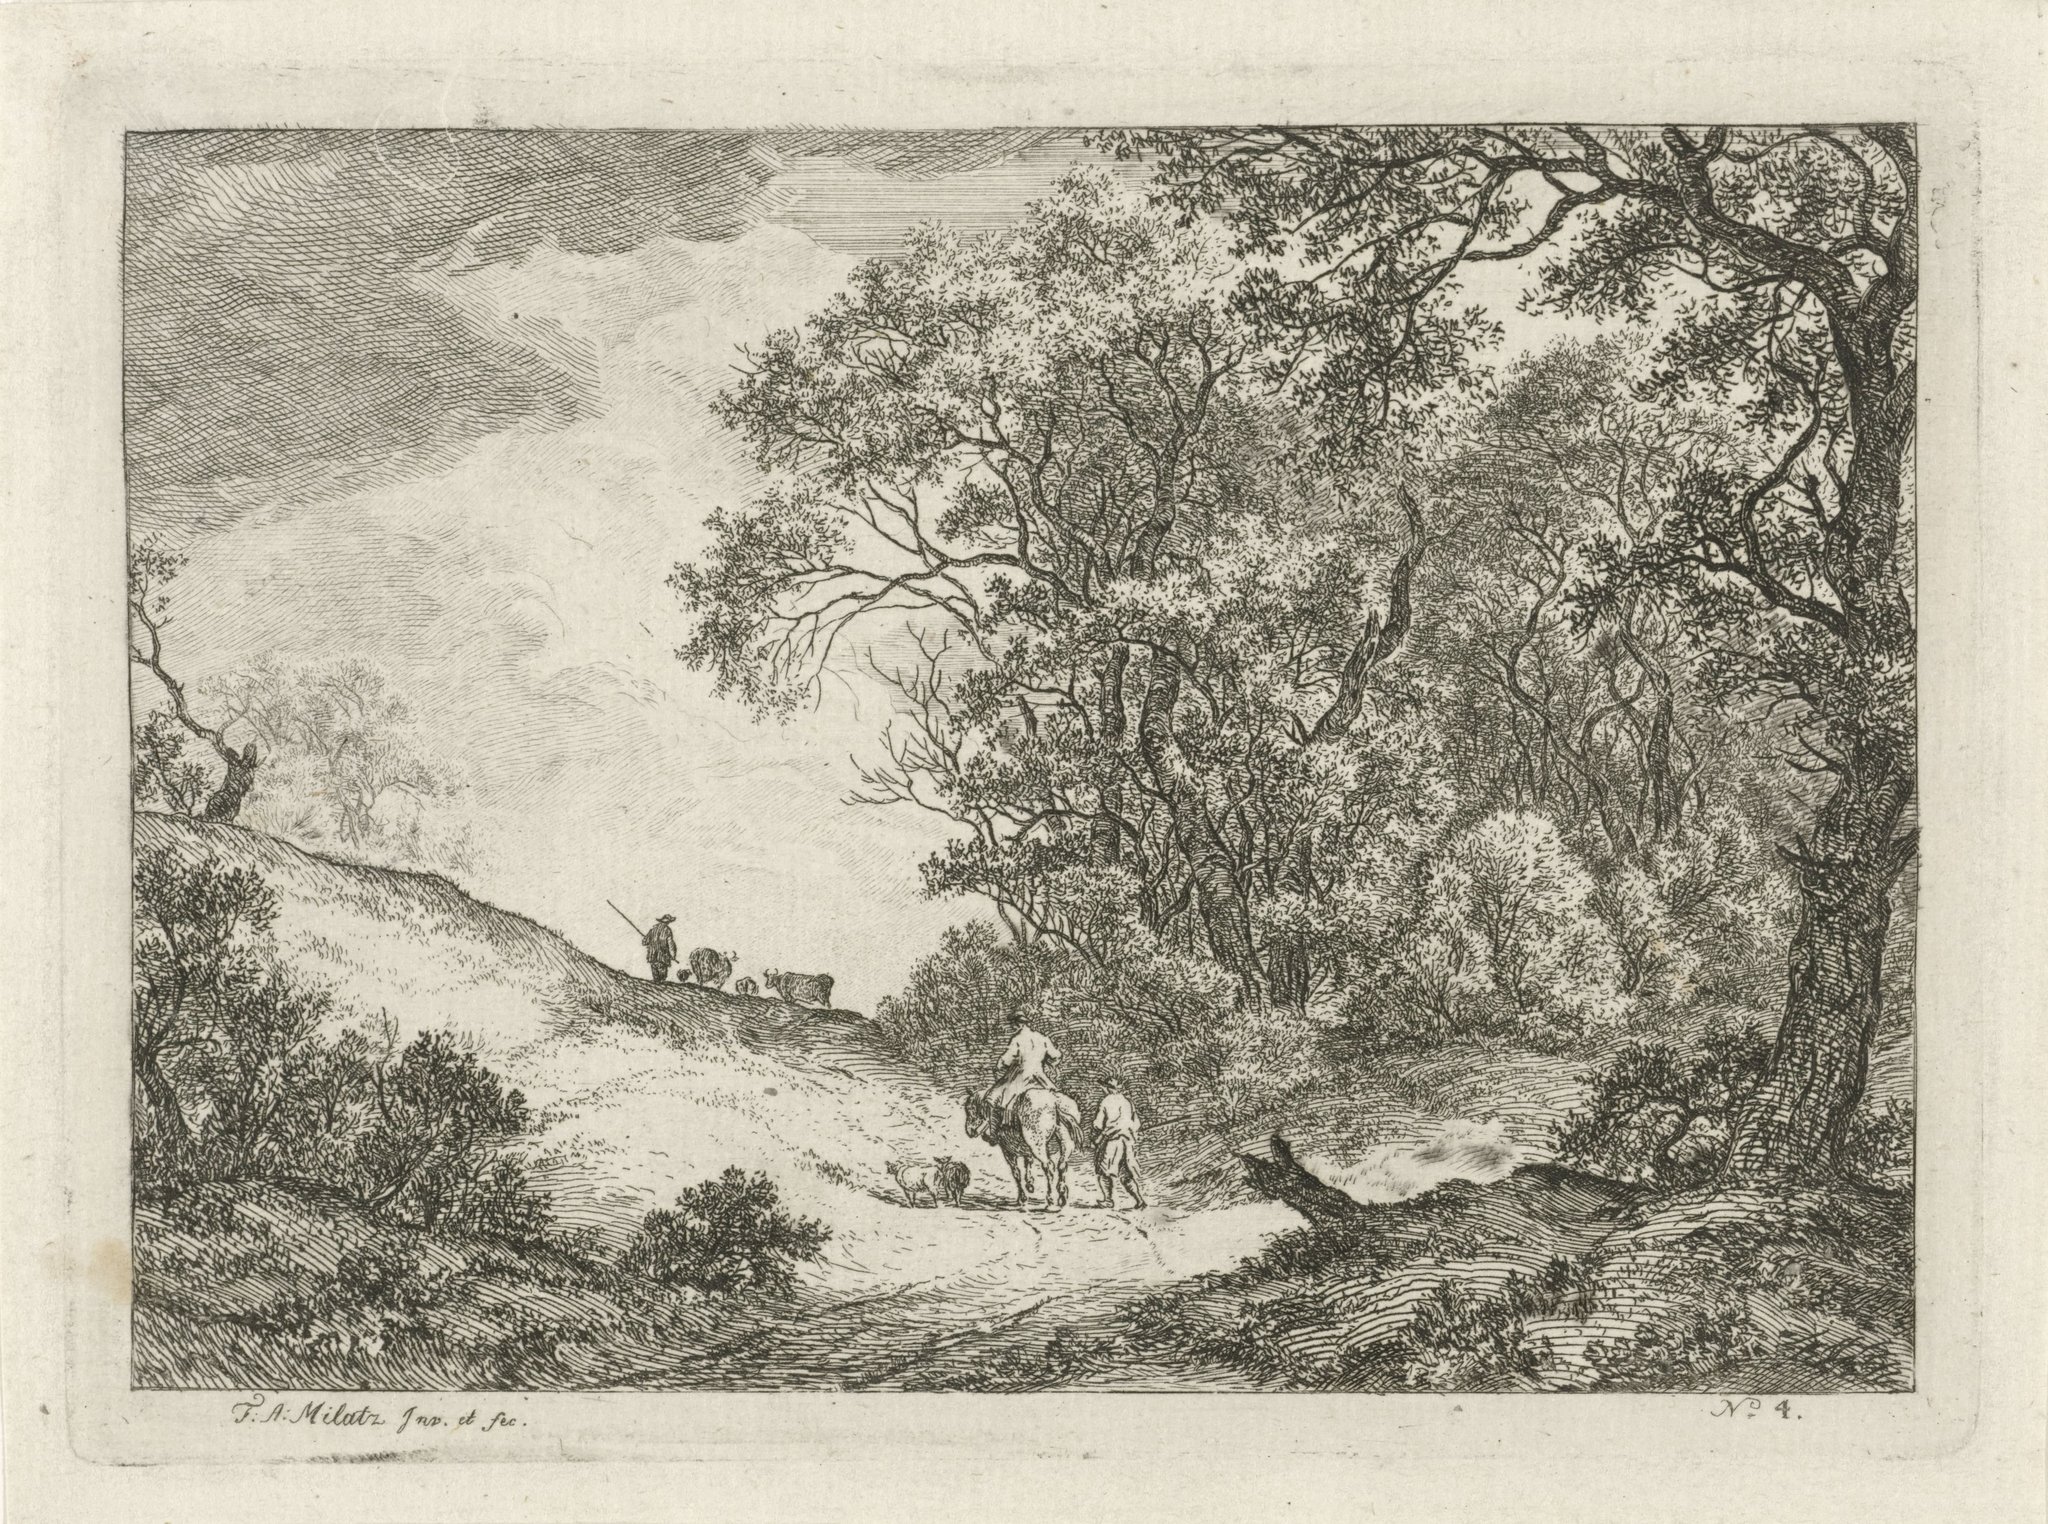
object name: print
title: Boomrijke landschappen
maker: franciscus andreas milatz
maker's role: draughtsman, painter, print maker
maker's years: 1764-1808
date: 1784-1808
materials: paper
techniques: etching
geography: haarlem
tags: riding a horse, ass, or mule; rider, horseman, trees, landscapes in the temperate zone, cattle driving, cattle driver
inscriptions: collector's mark: Lugt 2228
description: Een ruiter, veedrijvers, schapen en koeien in een boomrijk landschap.